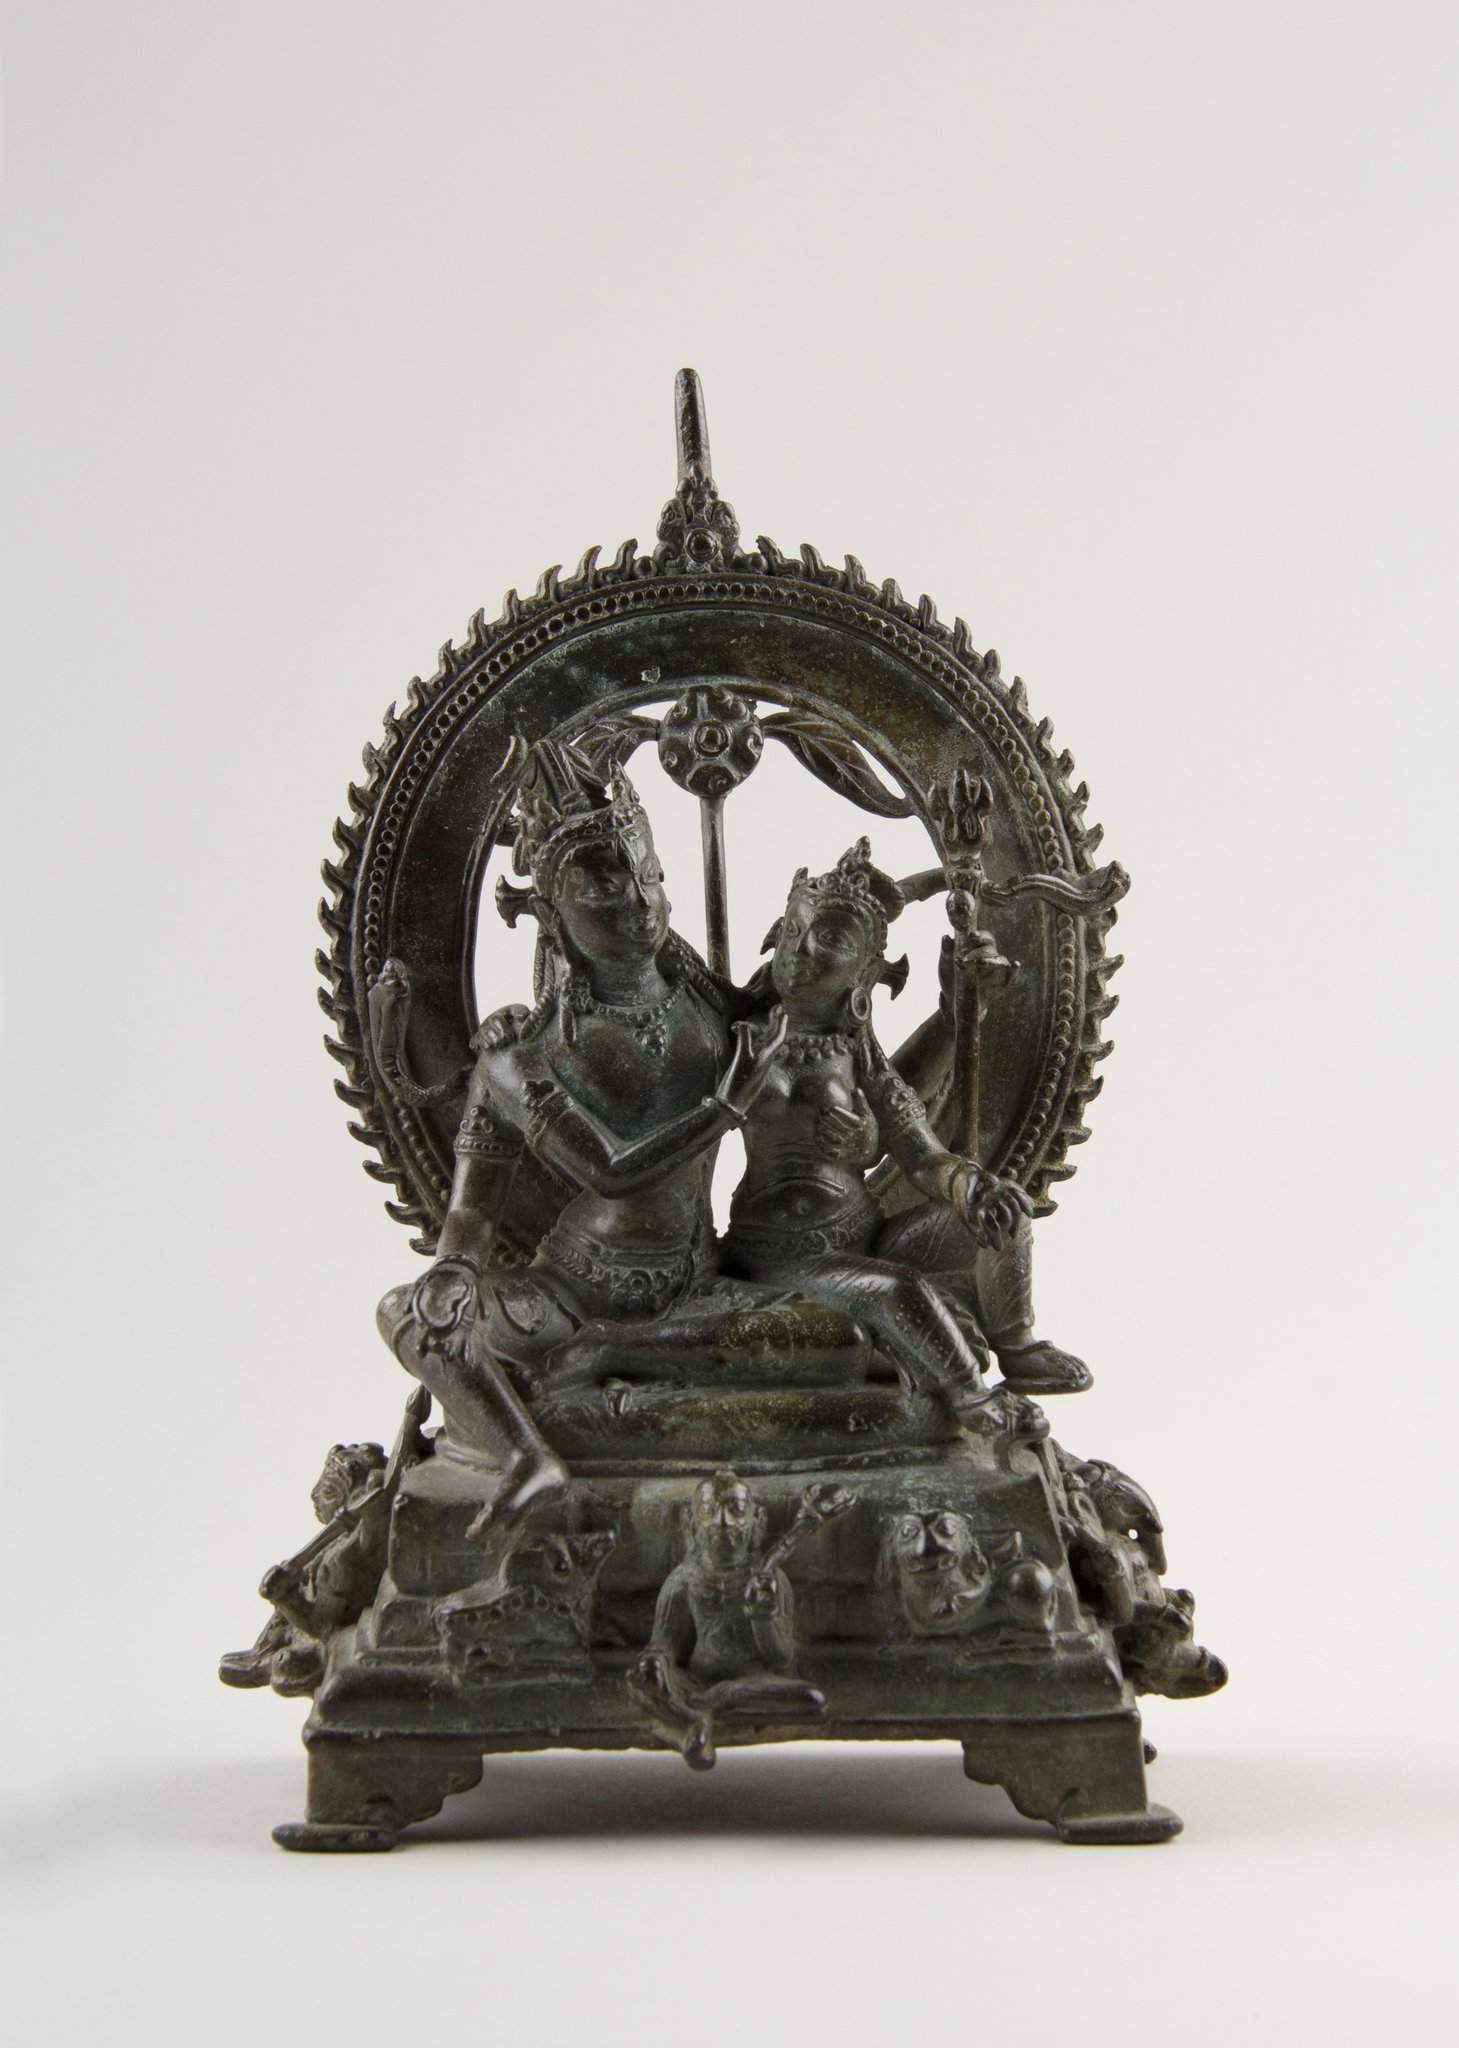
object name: statuette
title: Shiva Seated with Uma (Umamaheshvara)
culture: indian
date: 901-1000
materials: bronze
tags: shiva,hinduism